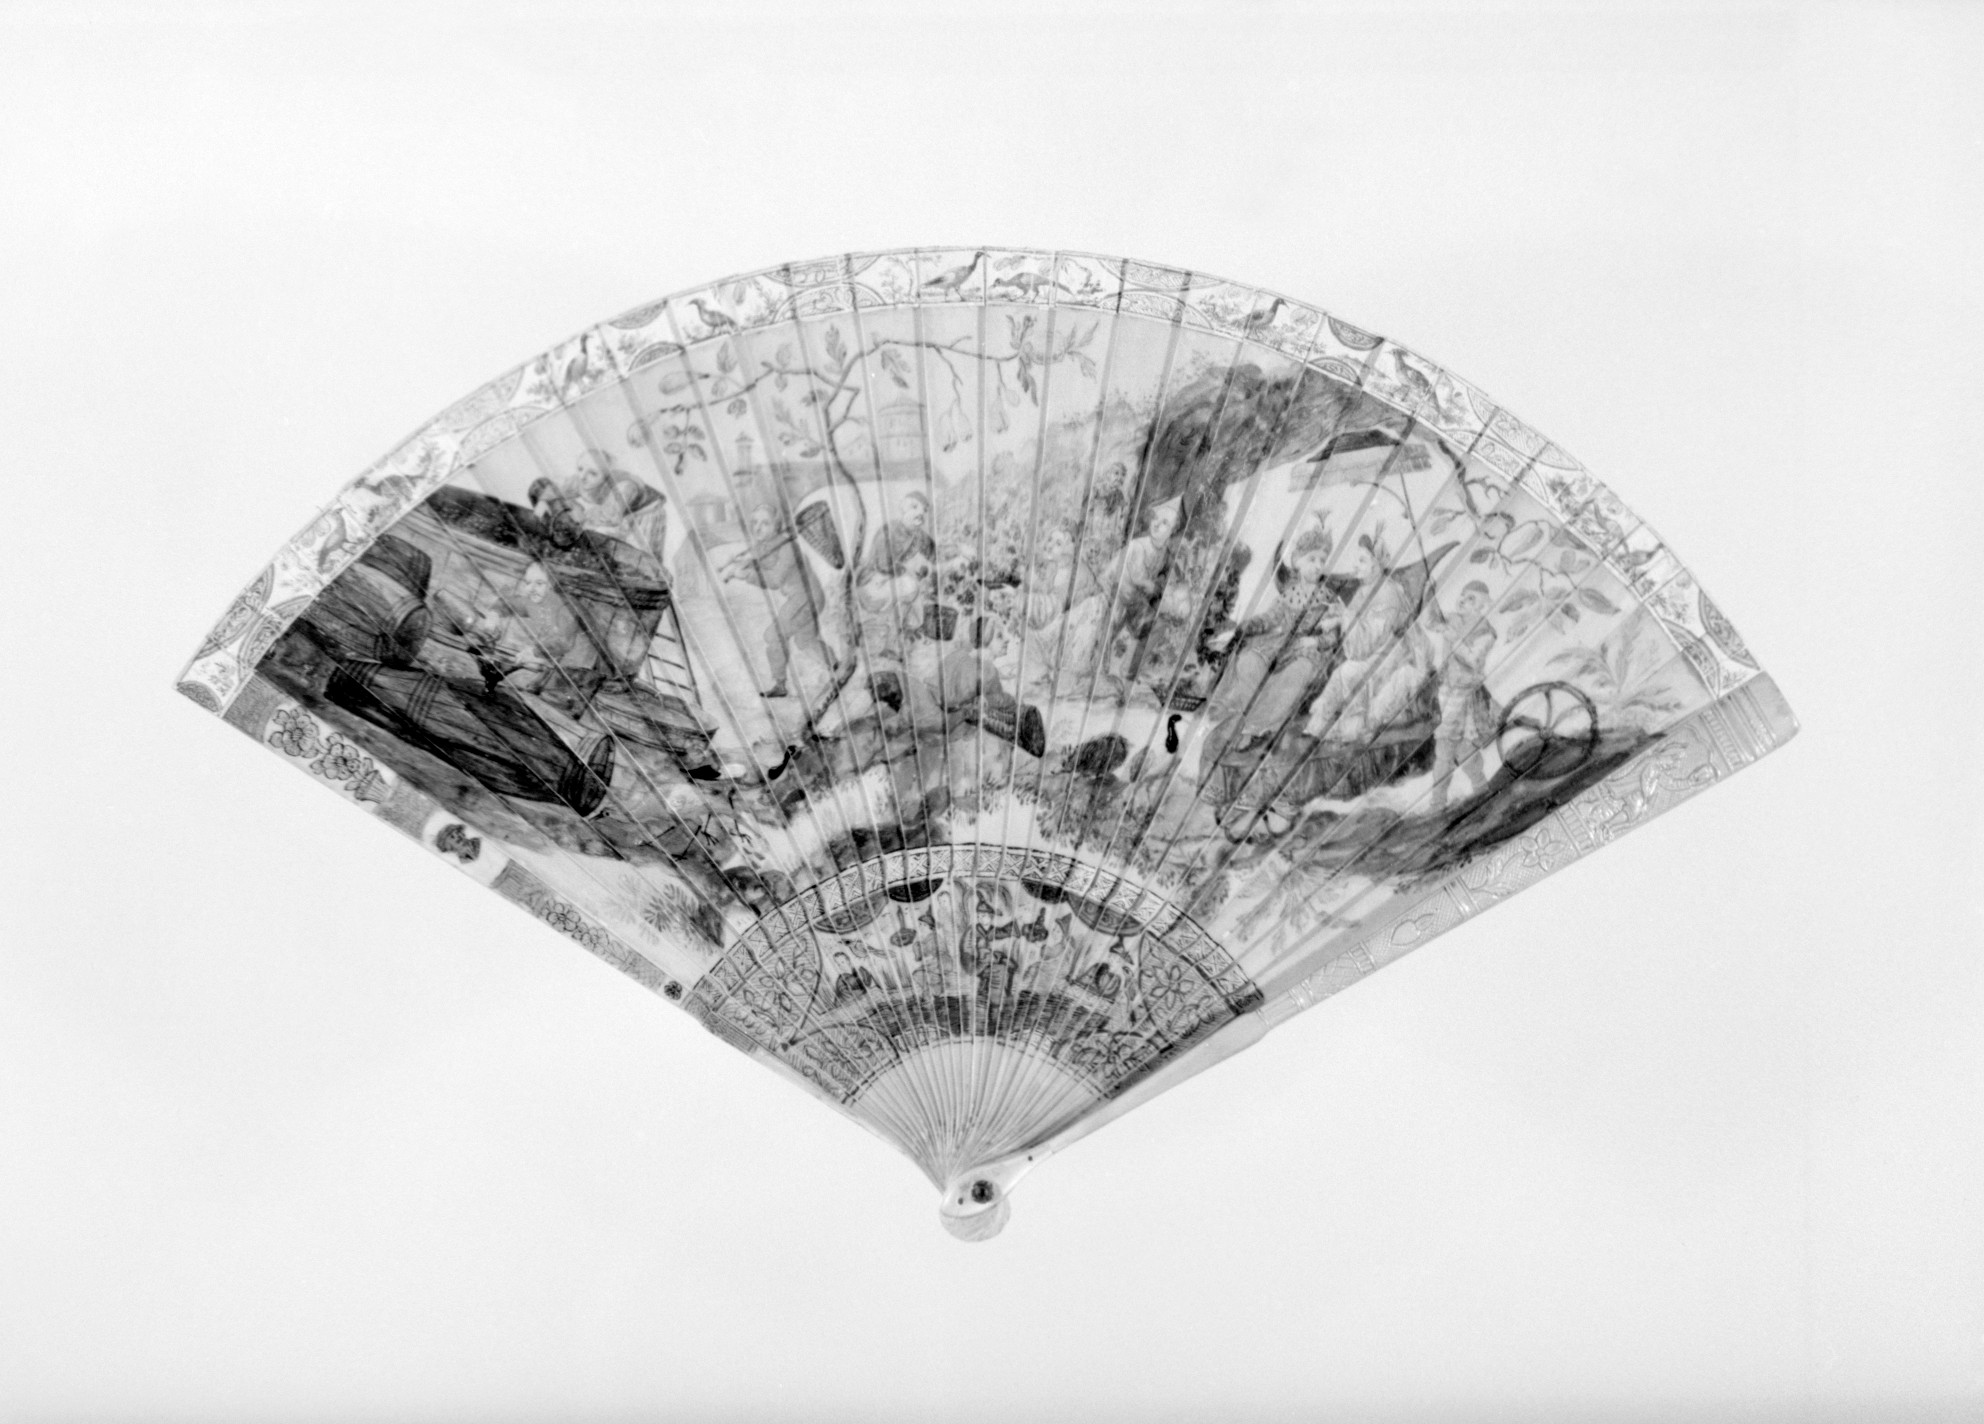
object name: fan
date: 1701-1800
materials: glass, ivory, mother of pearl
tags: men,women,working